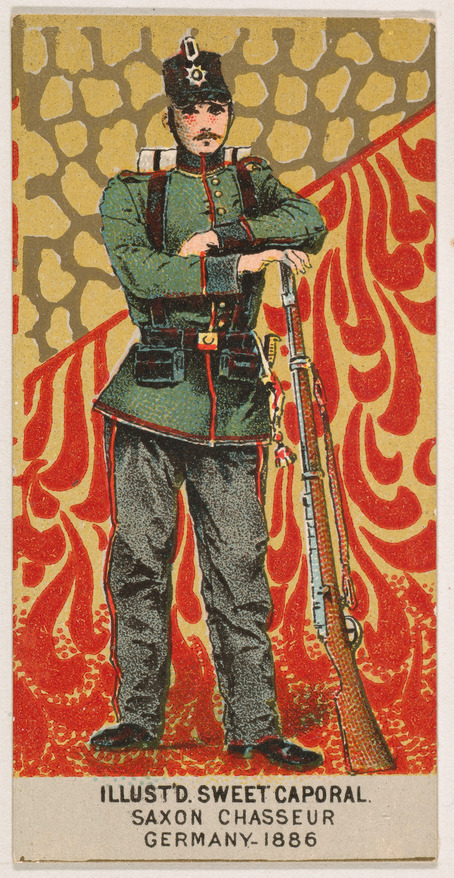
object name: print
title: Saxon Chasseur, Germany, 1886, from the Military Series (N224) issued by Kinney Tobacco Company to promote Sweet Caporal Cigarettes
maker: kinney brothers tobacco company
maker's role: publisher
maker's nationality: american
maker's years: 1869-2011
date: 1888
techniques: color lithograph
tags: soldiers,firearms,men